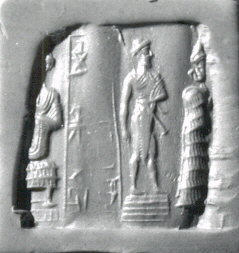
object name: cylinder seal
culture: babylonian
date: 1900-1501 BCE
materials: mineral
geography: mesopotamia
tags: men